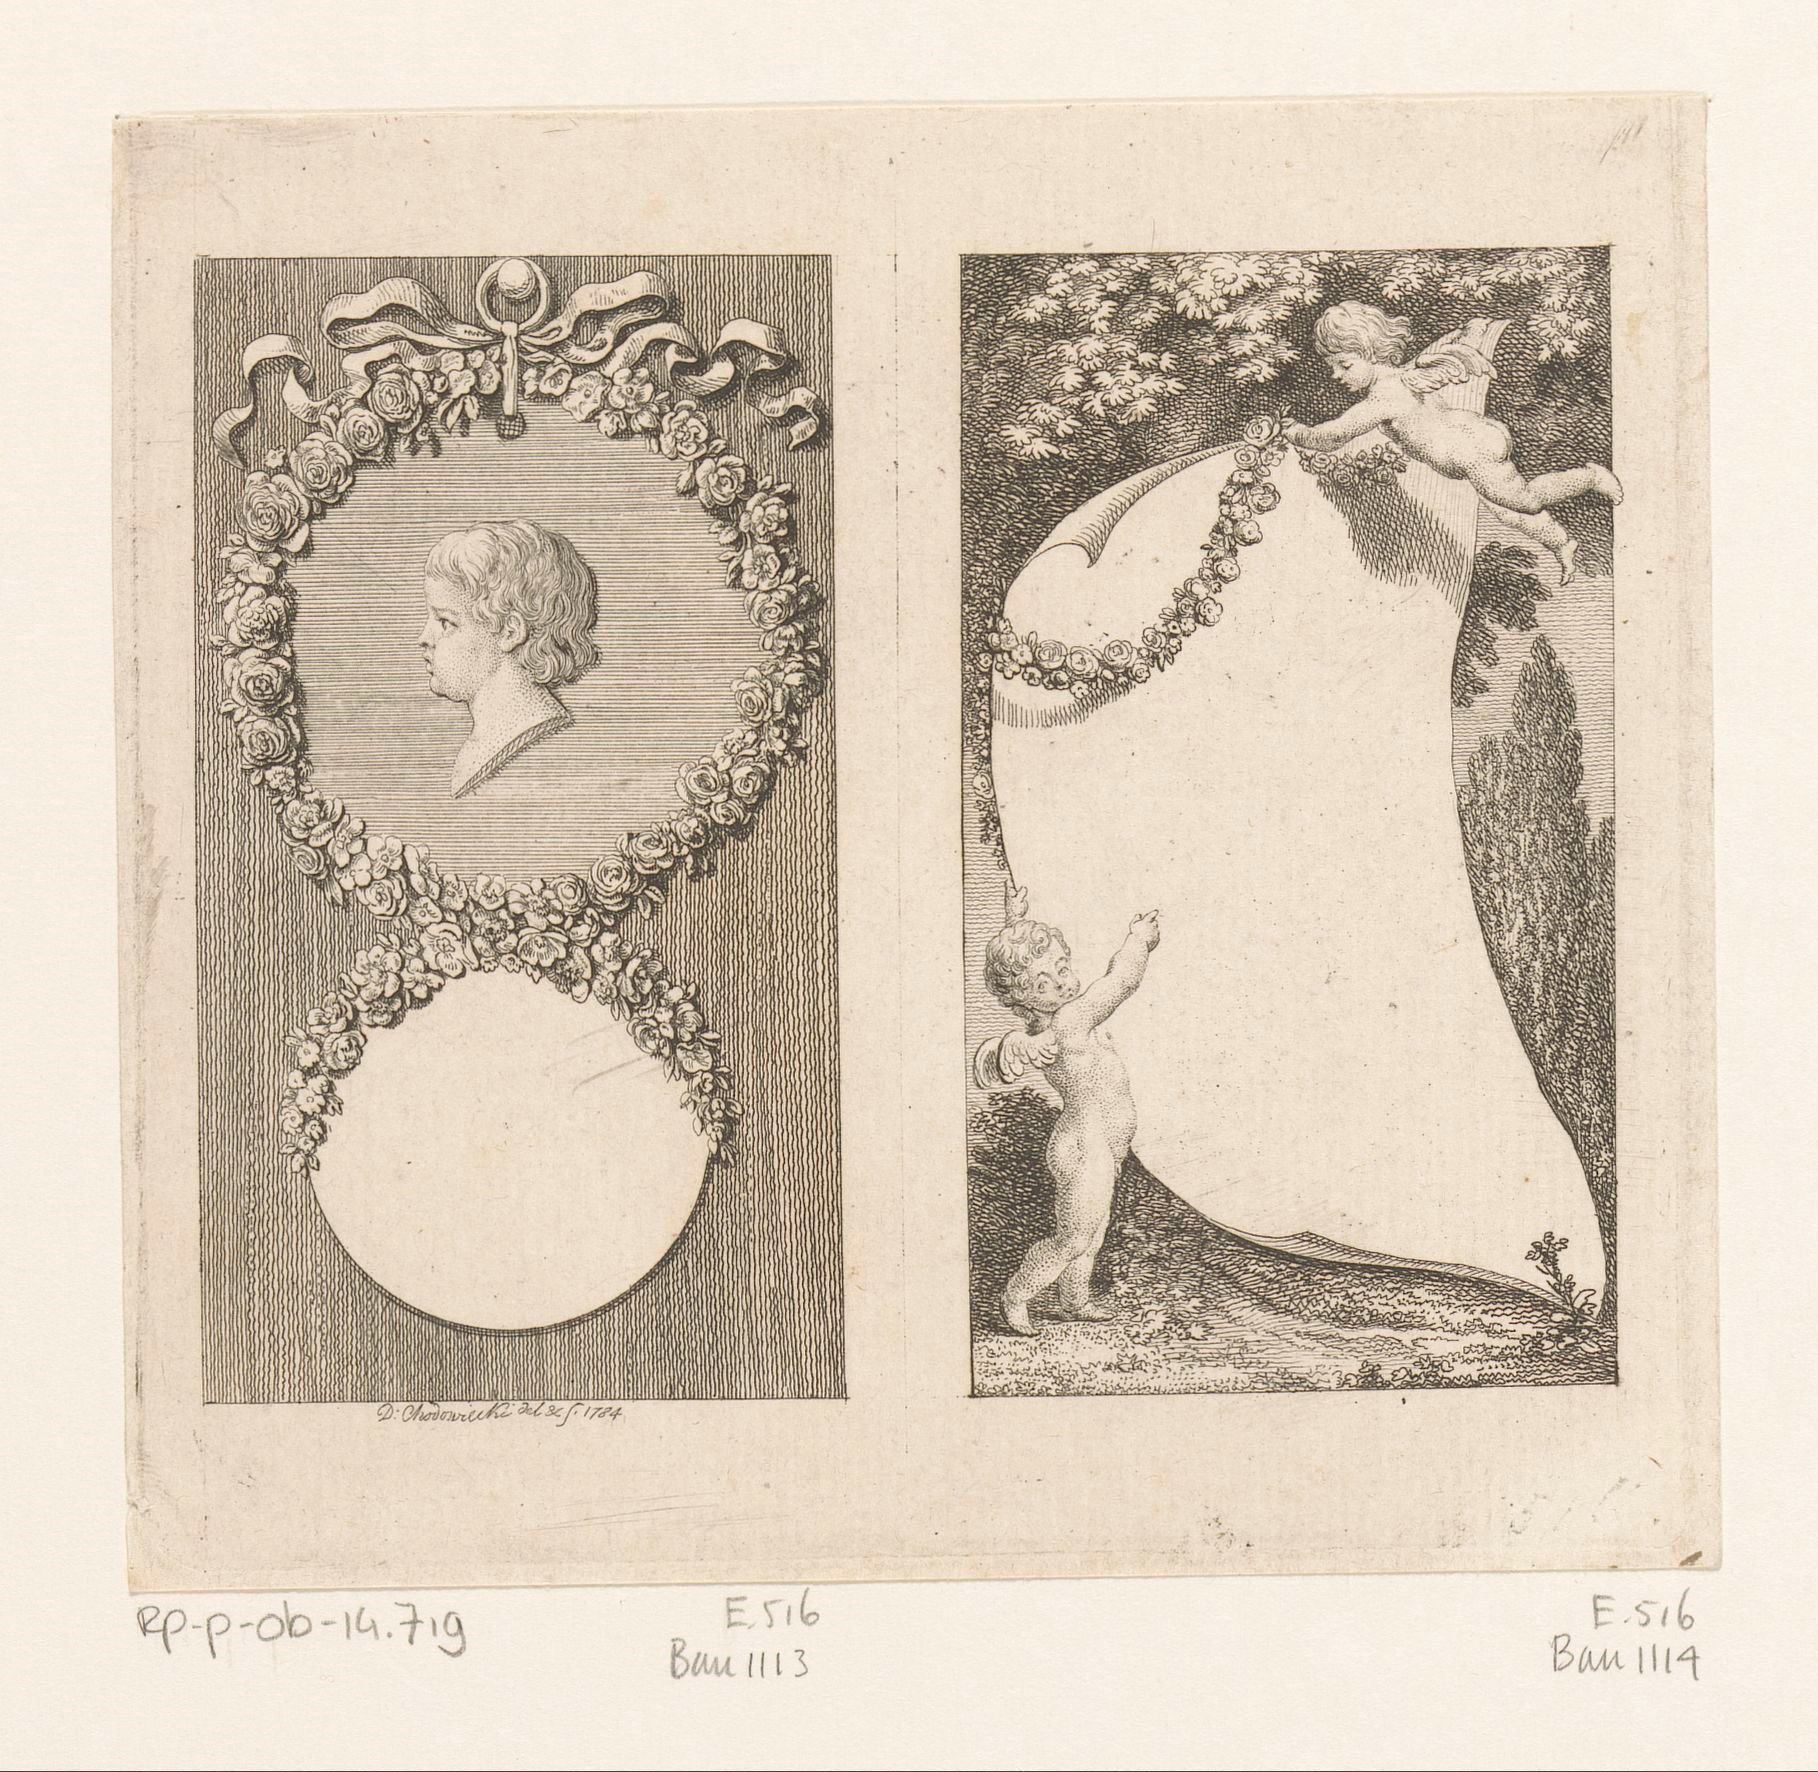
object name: print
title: Portret van Amelia en een door putti opgehouden blanco blad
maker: daniel nikolaus chodowiecki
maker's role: draughtsman, print maker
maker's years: 1726-1801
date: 1784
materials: paper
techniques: etching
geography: berlin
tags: ornament ~ medallion, historical persons, ornament ~ festoon, garland, cupids: 'amores', 'amoretti', 'putti'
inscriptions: collector's mark: Lugt 2228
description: Prenten gebruikt voor: Konigl. Grosbrit. Genealogischen Kalender auf das Jahr 1785. Lauenburg: J. G. Berenberg, 1784.